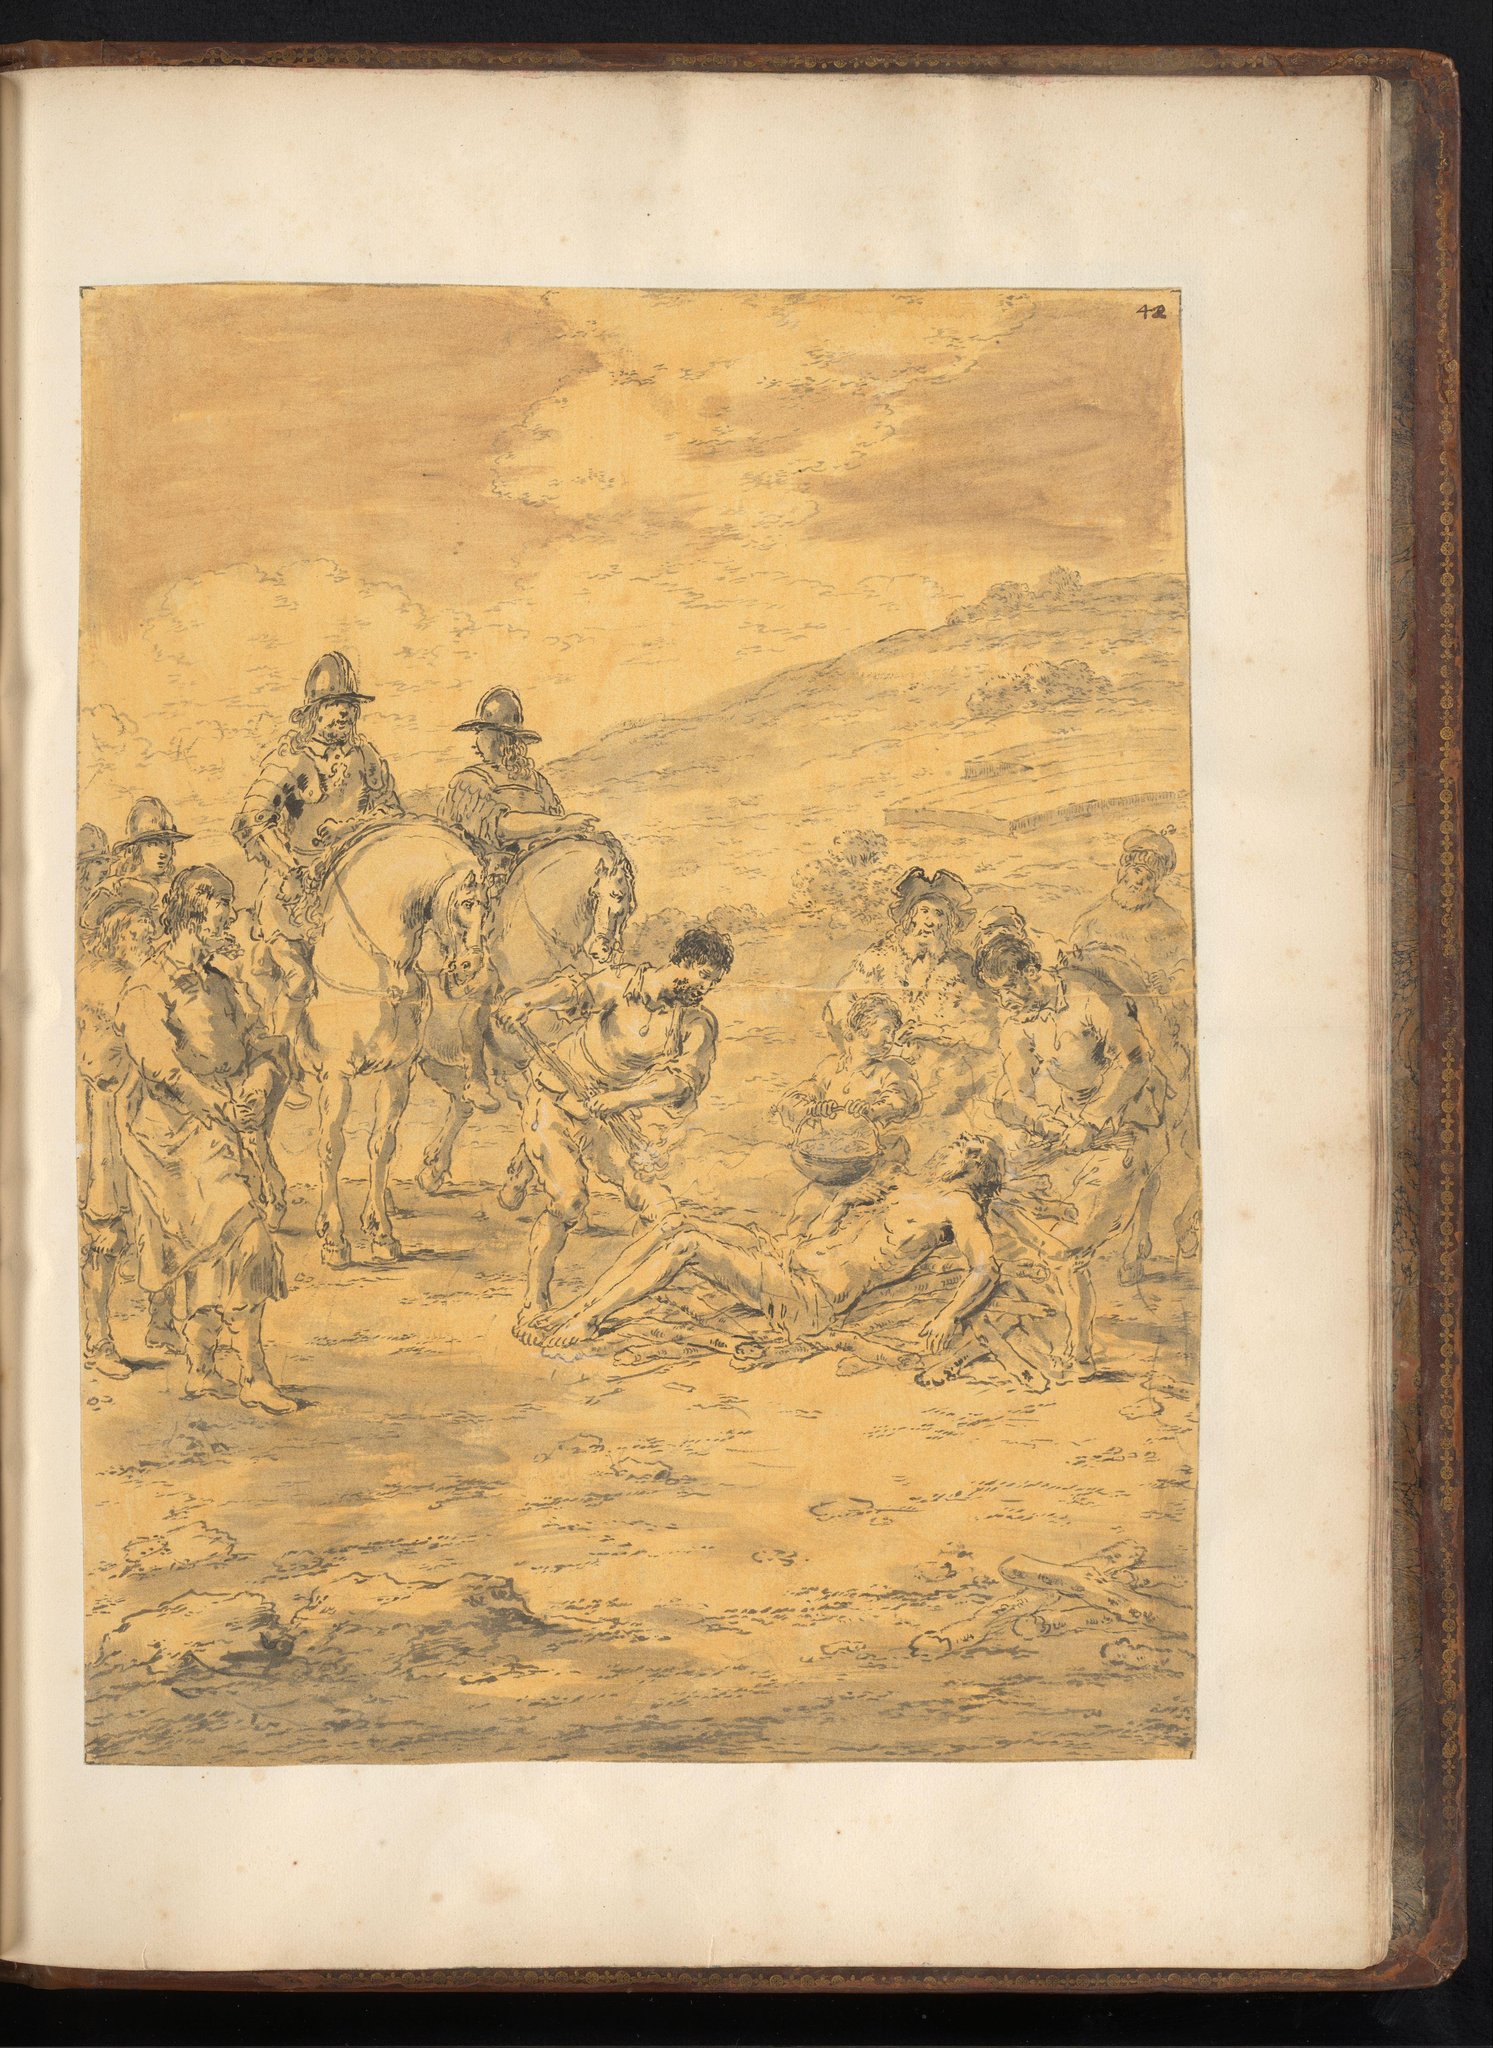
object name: drawing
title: Calenus doet een stapel houdt maken, leit sijn hem selven daar op, en laat hem tot as verbranden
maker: leonaert bramer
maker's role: draughtsman, painter, print maker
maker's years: 1596-1674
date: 1655-1665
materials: paint, ink, paper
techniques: brush, pen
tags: (story of) alexander the great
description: Rechts ligt de gymnosofist Calanus op een brandstapel die op het punt staat om aangestoken te worden door de omringende personen. Links staat een groepje mensen, onder wie een aantal soldaten, toe te kijken. Rechtsboven genummerd: 42. Tekening maakt deel uit van een album.